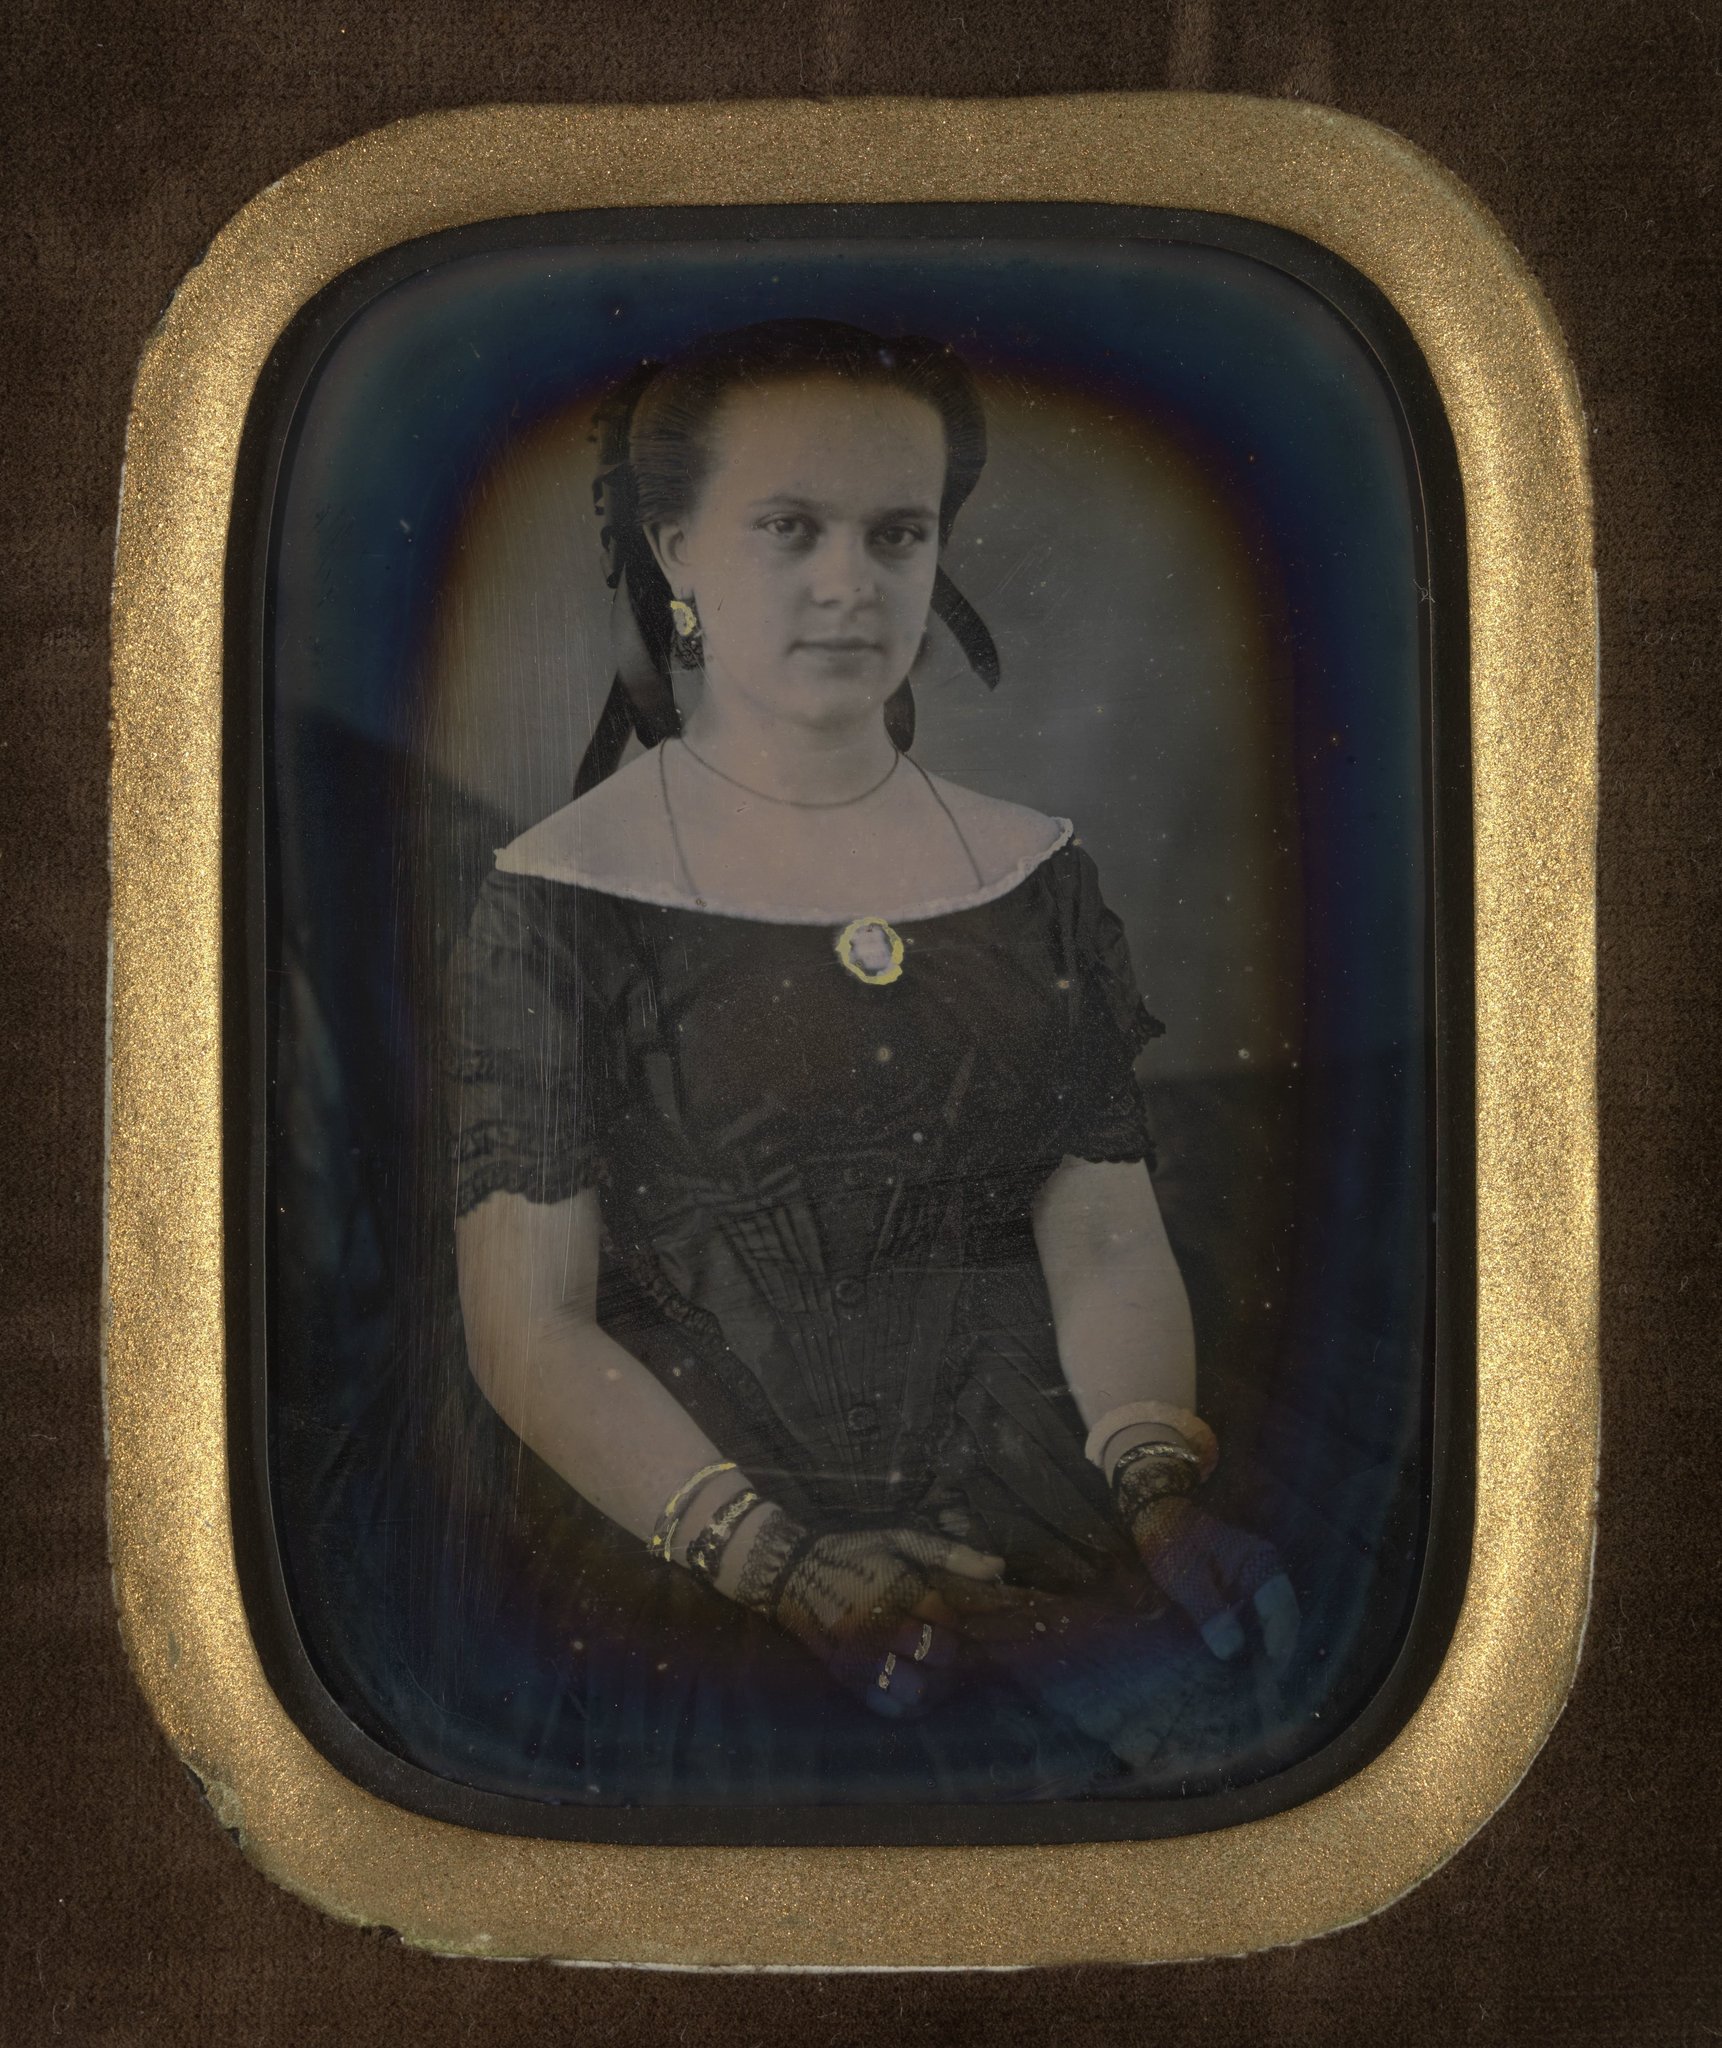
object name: photograph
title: Portret van Margaretha Jacoba Wiggers van Kerchem, echtgenote van Geldolph Adriaan de Lange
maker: d.h. racine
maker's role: fotograaf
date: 1850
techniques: daguerreotype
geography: batavia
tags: dutch east indies, the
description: Datering is afgeleid van de leefjaren van mevrouw Wiggers van Kerchem. Margaretha Jacoba Wiggers van Kerchem is de echtgenote van Geldolph Adriaan de Lange. Margaretha Jacoba Wiggers van Kerchem is de moeder van Jeannette de Lange, afgebeeld op ons Toorop-schilderij SK-A-4989 en echtgenote van Geldolph Adriaan de Lange RP-P-2010-175. [M. Boom, 2010-10-26]